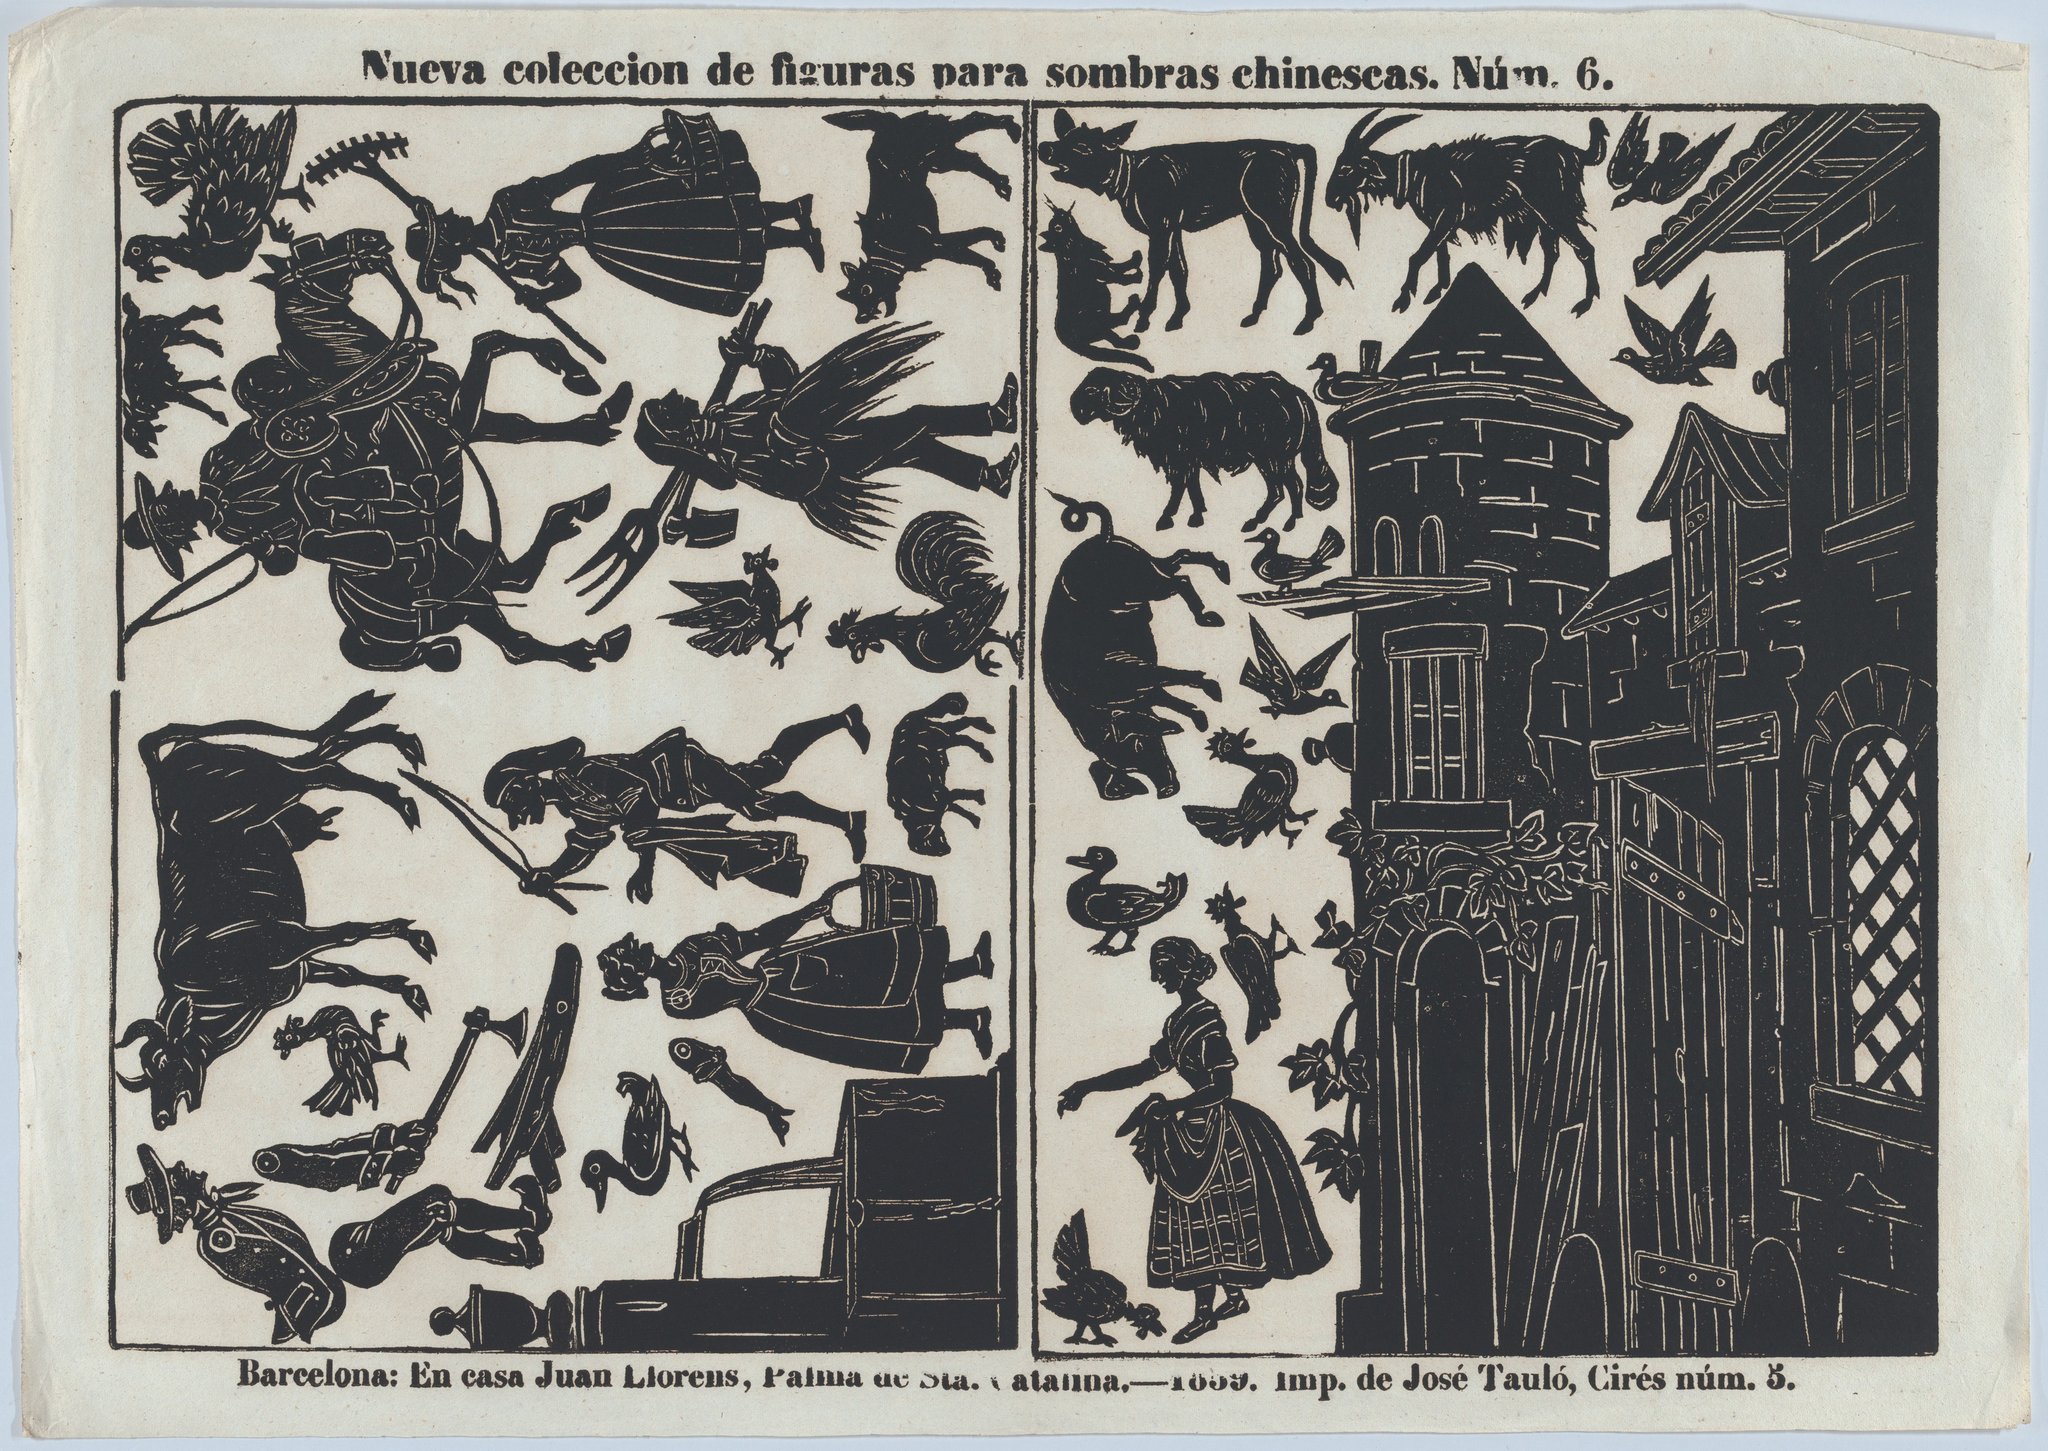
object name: print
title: Sheet 6 of figures for Chinese shadow puppets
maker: juan llorens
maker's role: publisher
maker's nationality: spanish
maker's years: 1800-1900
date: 1859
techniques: engraving, woodcut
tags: chickens,ducks,men,women,cows,goats,horses,pigs,puppets